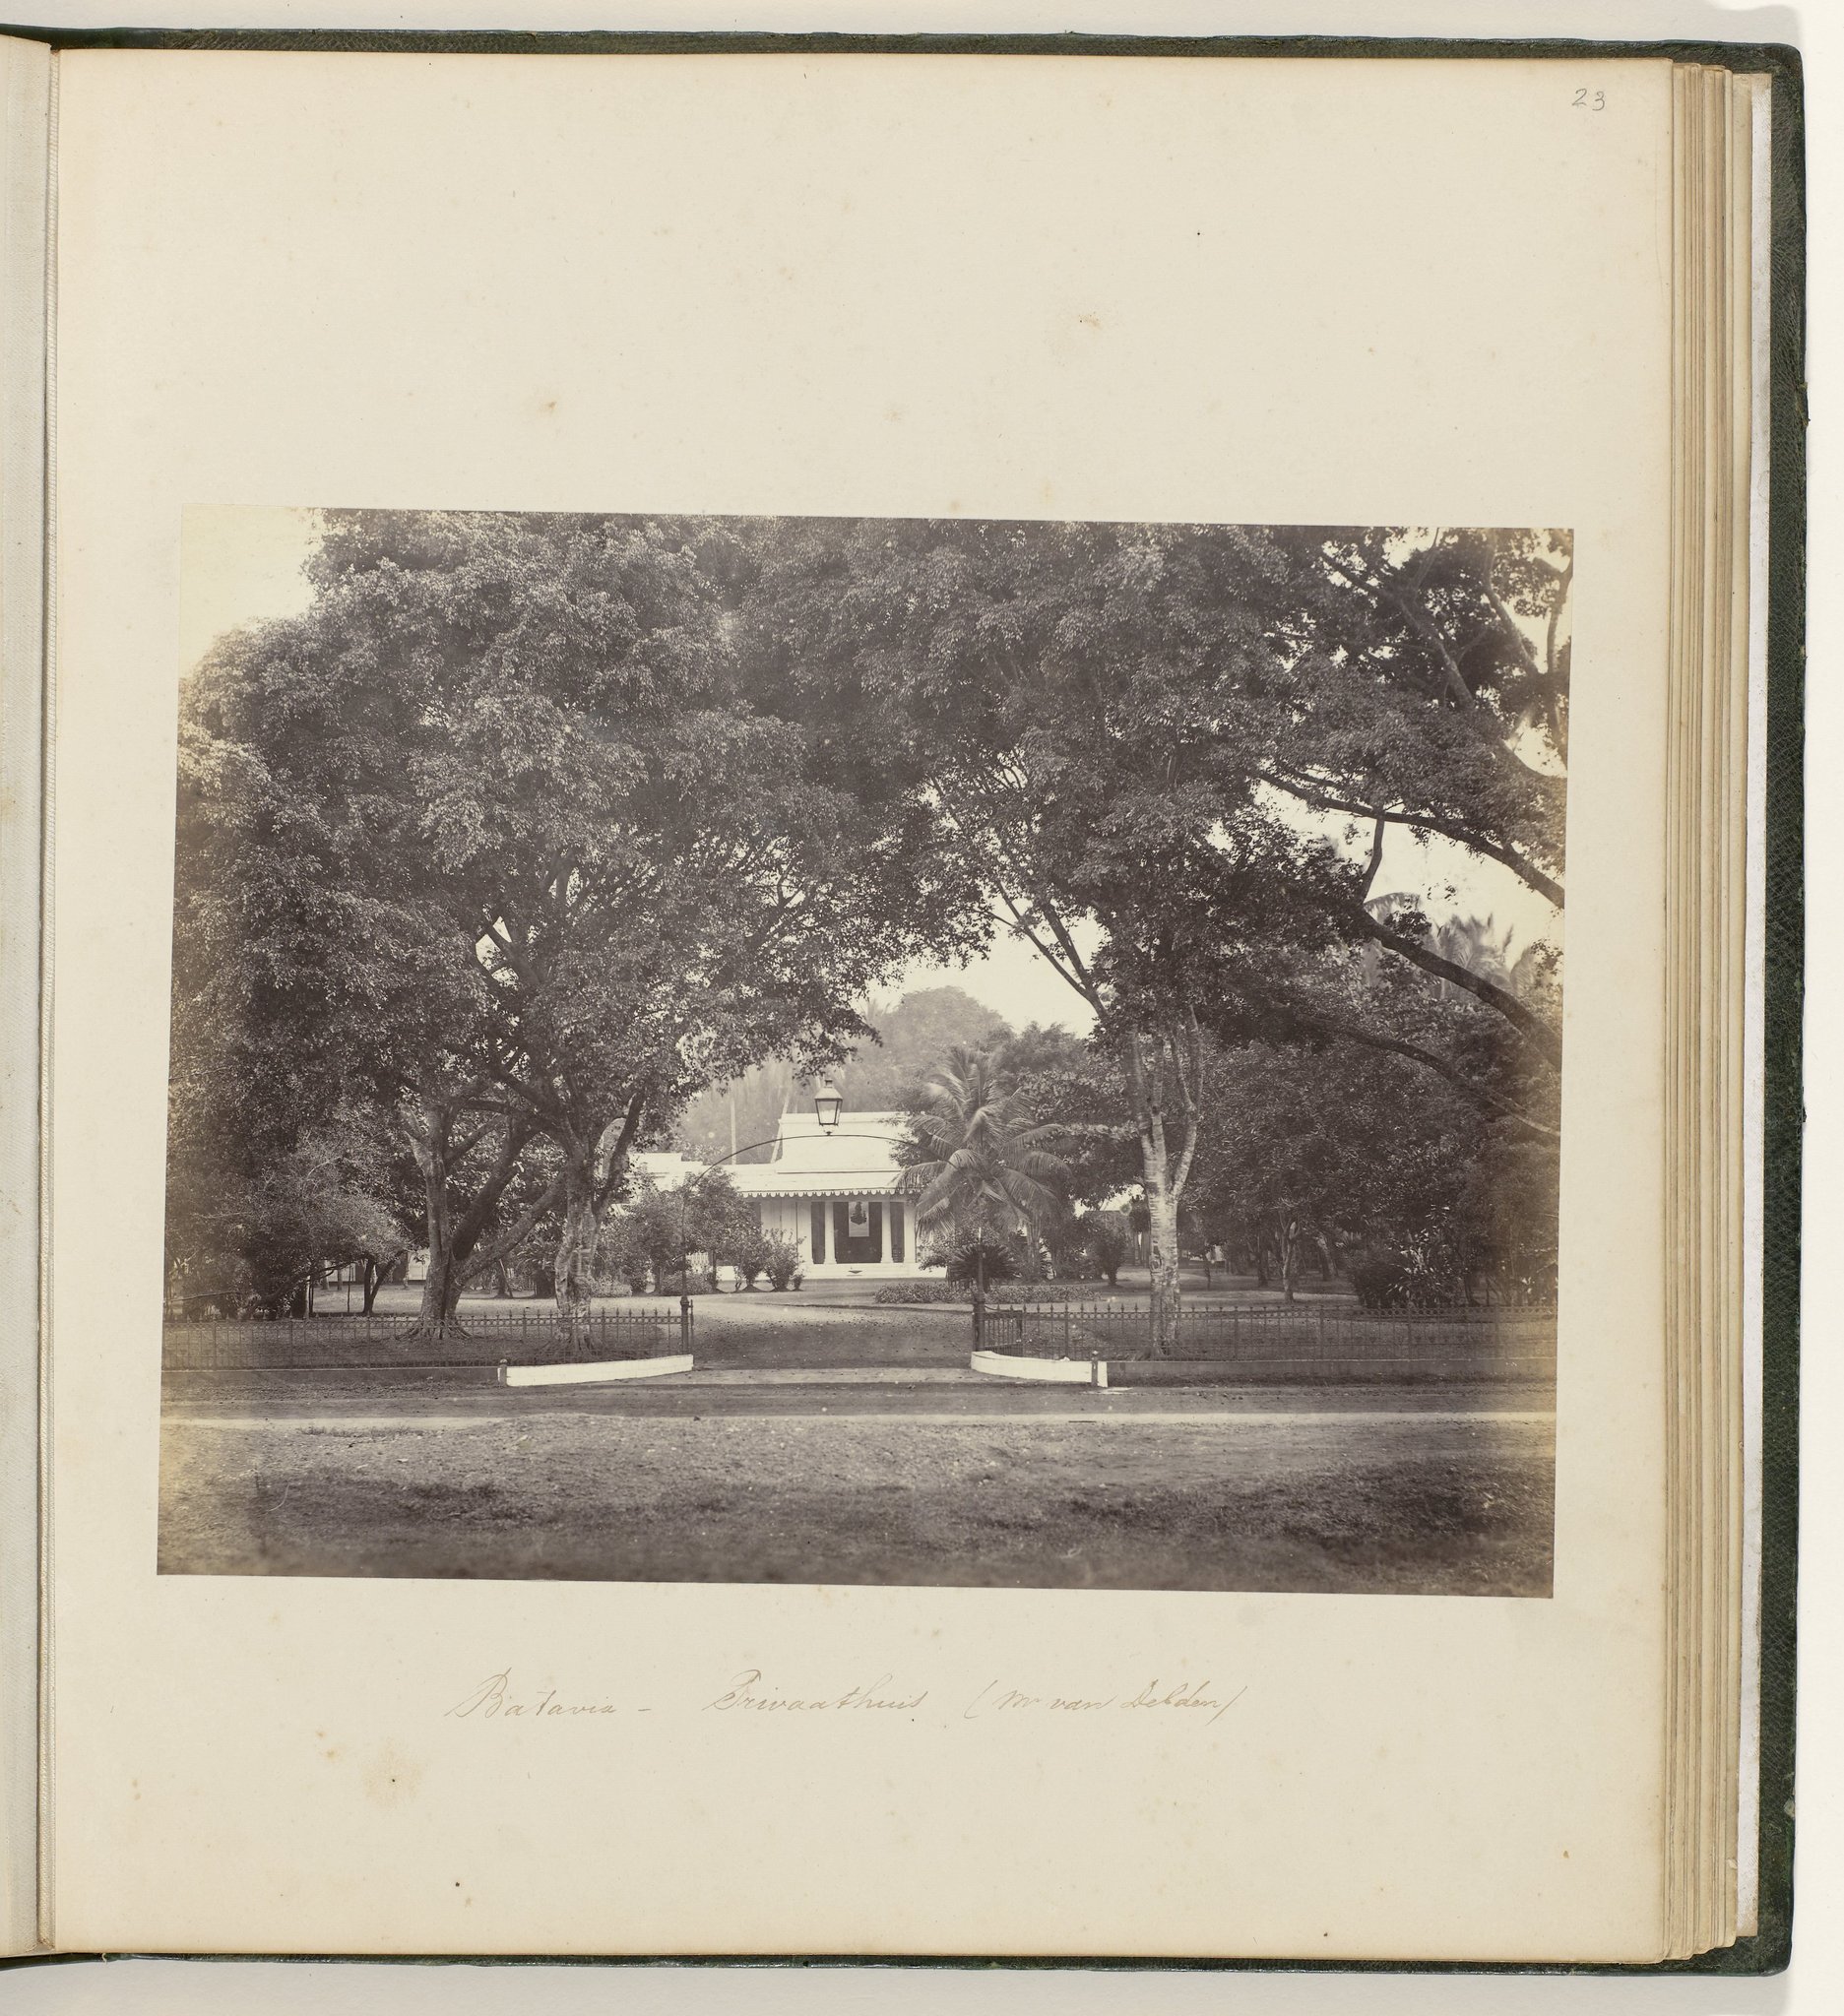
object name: photograph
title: Batavia - Privaathuis (mr. van Delden)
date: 1863-1866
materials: photographic support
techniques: albumen print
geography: batavia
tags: detached house in city, batavia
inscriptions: inscription: ‘Batavia - Privaathuis (mr. van Delden)’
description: Gezicht op het woonhuis van dhr. Ambrosius J.W. van Delden te Batavia. Gezicht door bomen op het huis met tuin vanaf de weg. Onderdeel van het tweede groene fotoalbum met foto's van Java, uit het bezit van apotheker Specht-Grijp, die in 1865 vanuit Batavia naar Nederland terugkeerde.